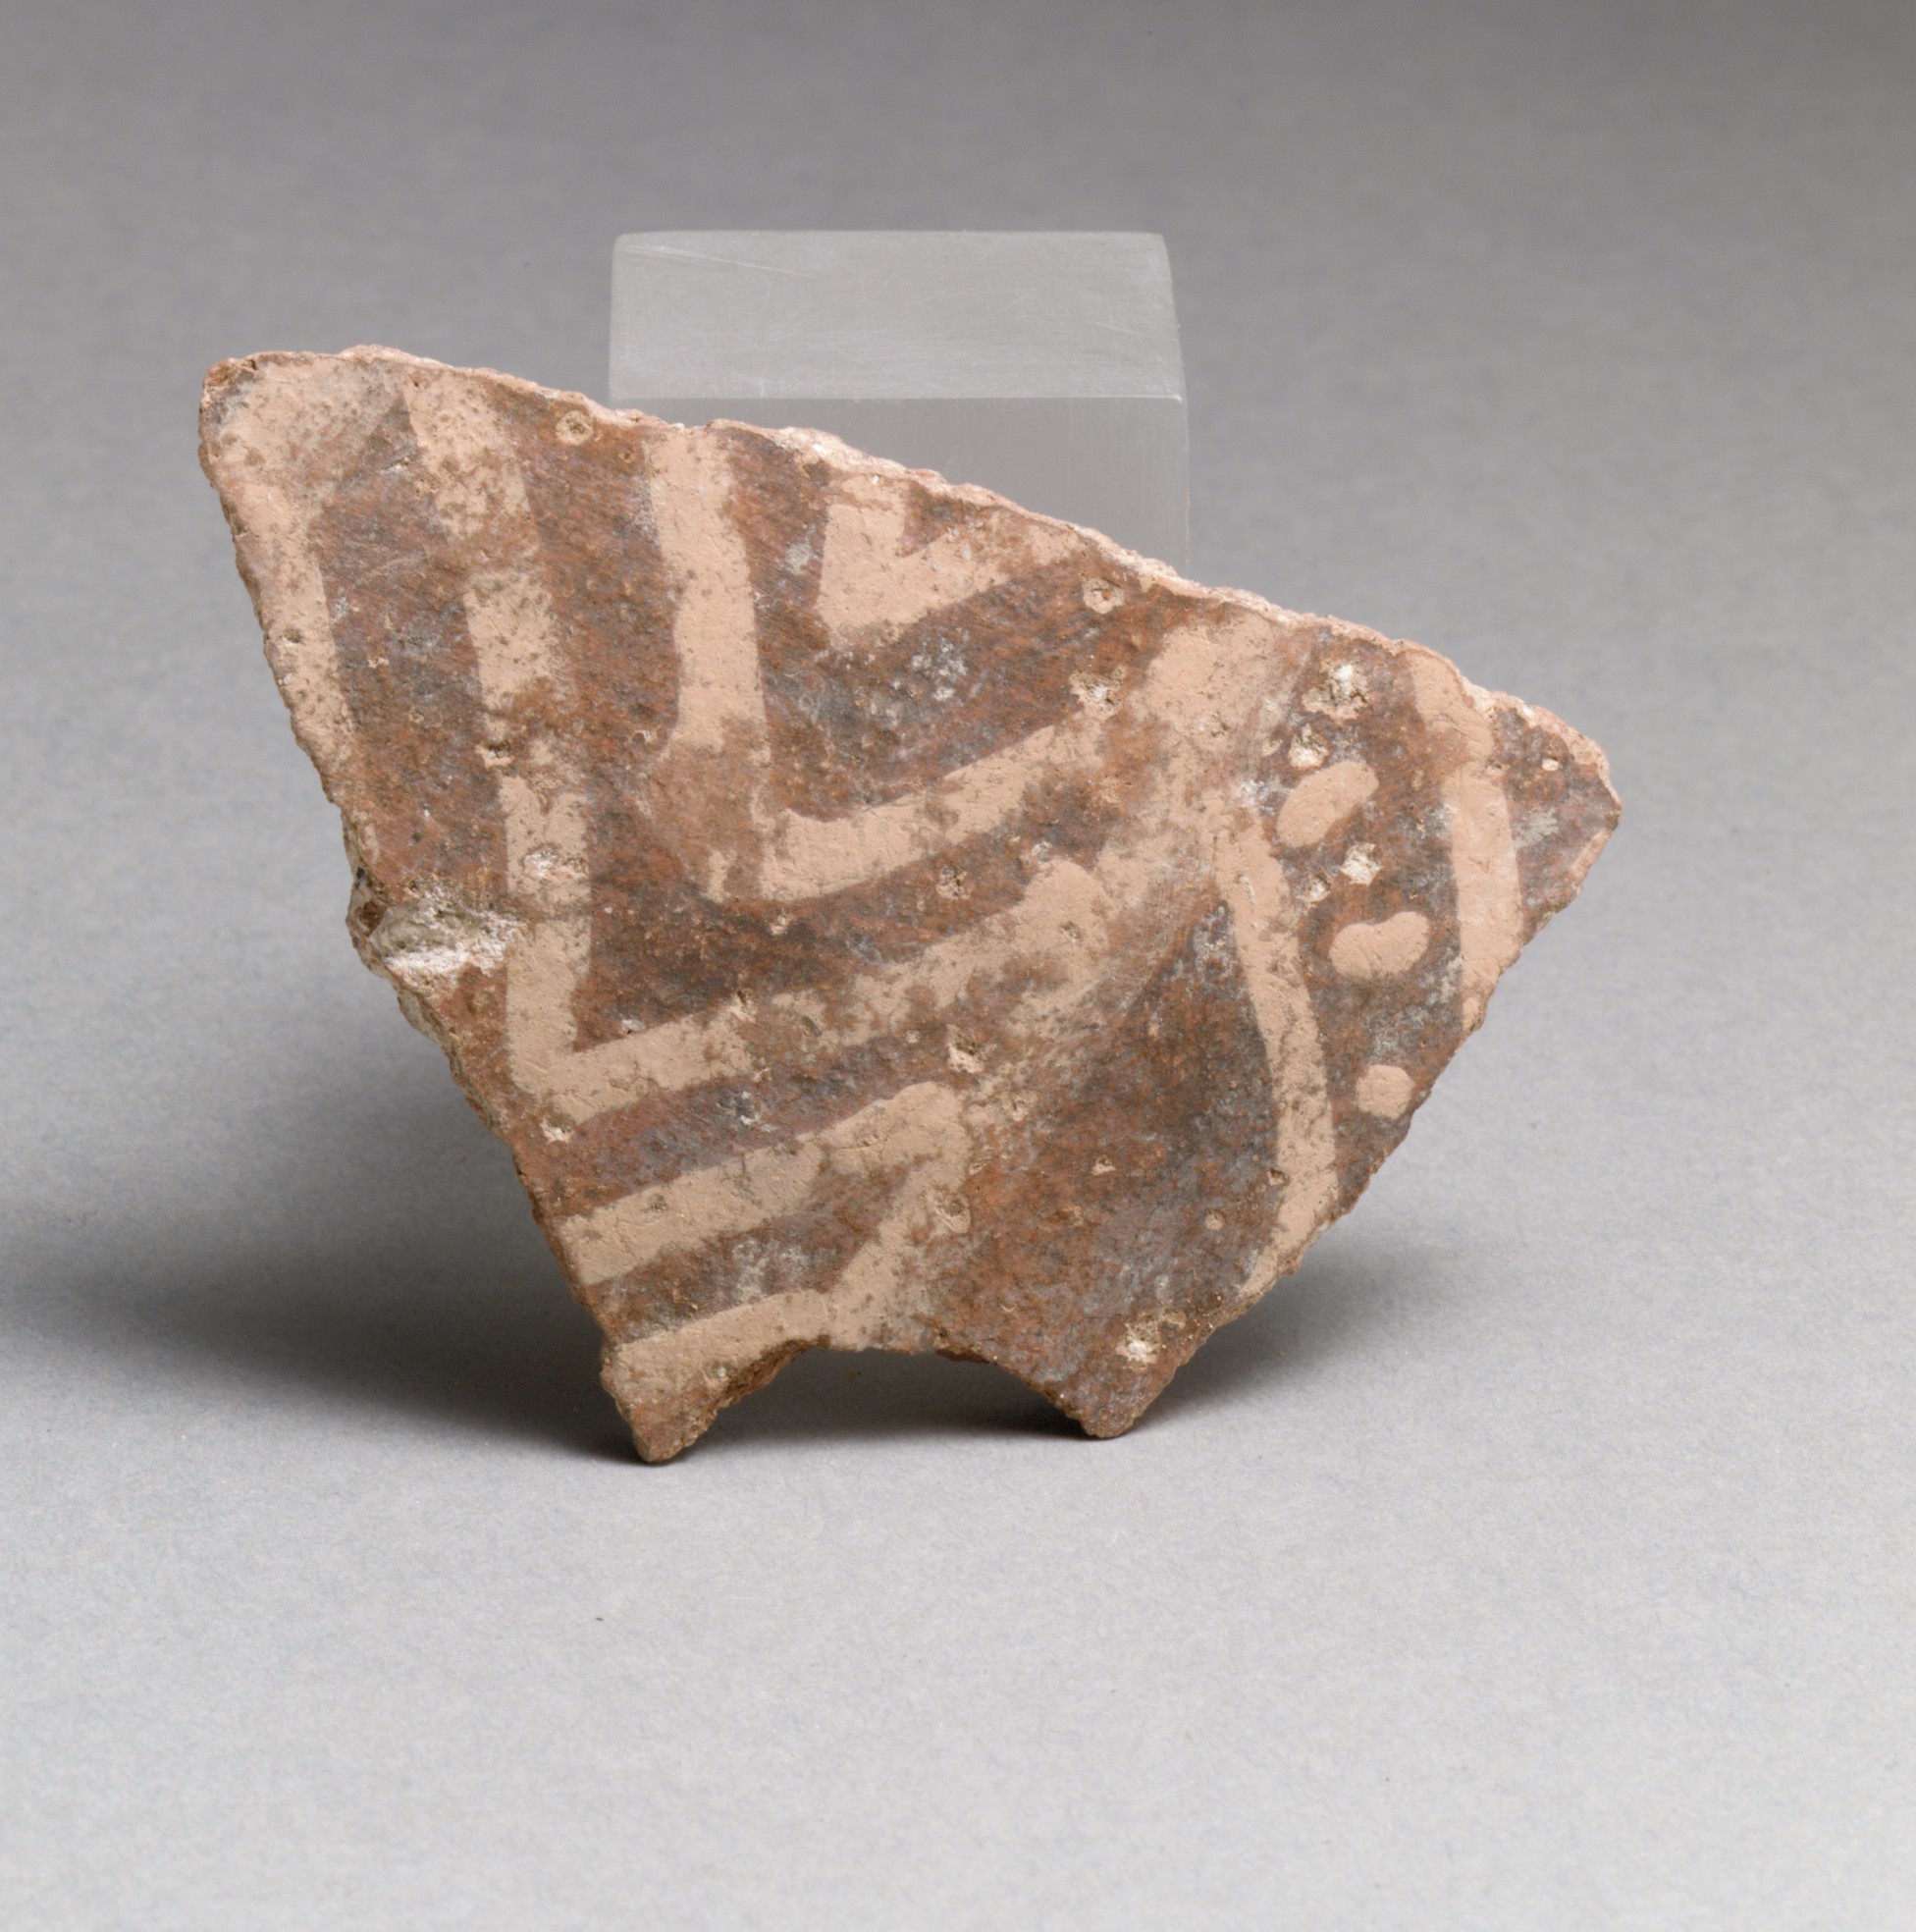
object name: vase fragment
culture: minoan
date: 2600-2000 BCE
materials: terracotta